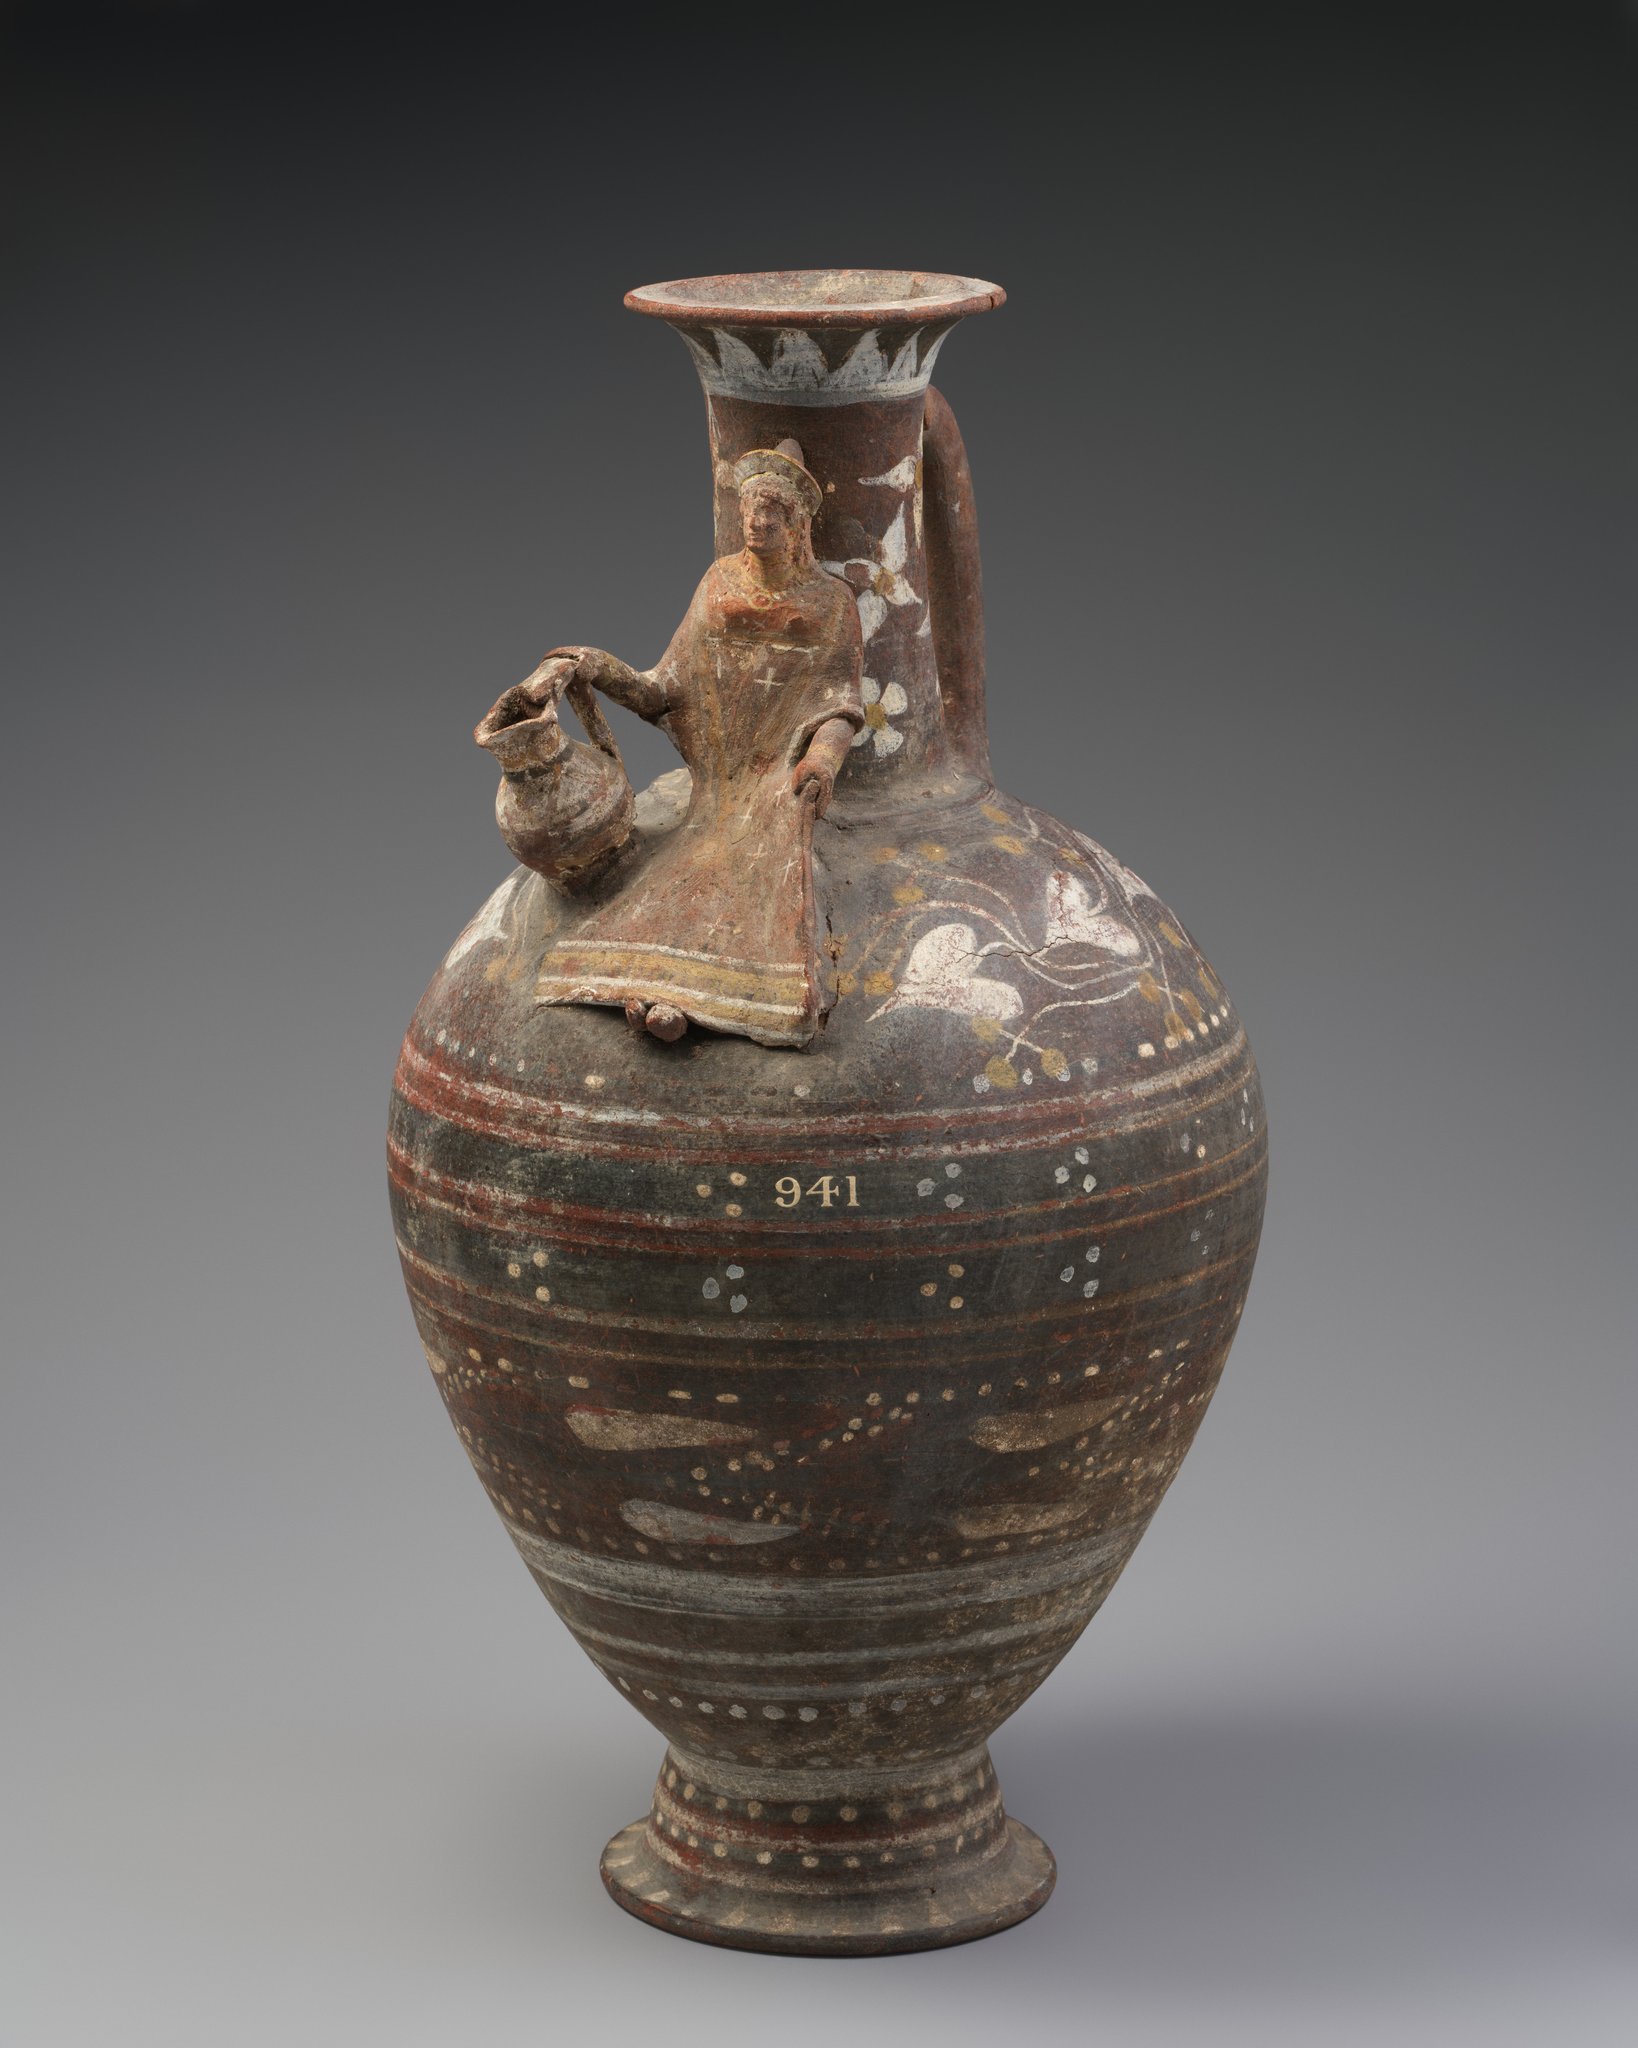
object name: vase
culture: cypriot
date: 400-310 BCE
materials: terracotta